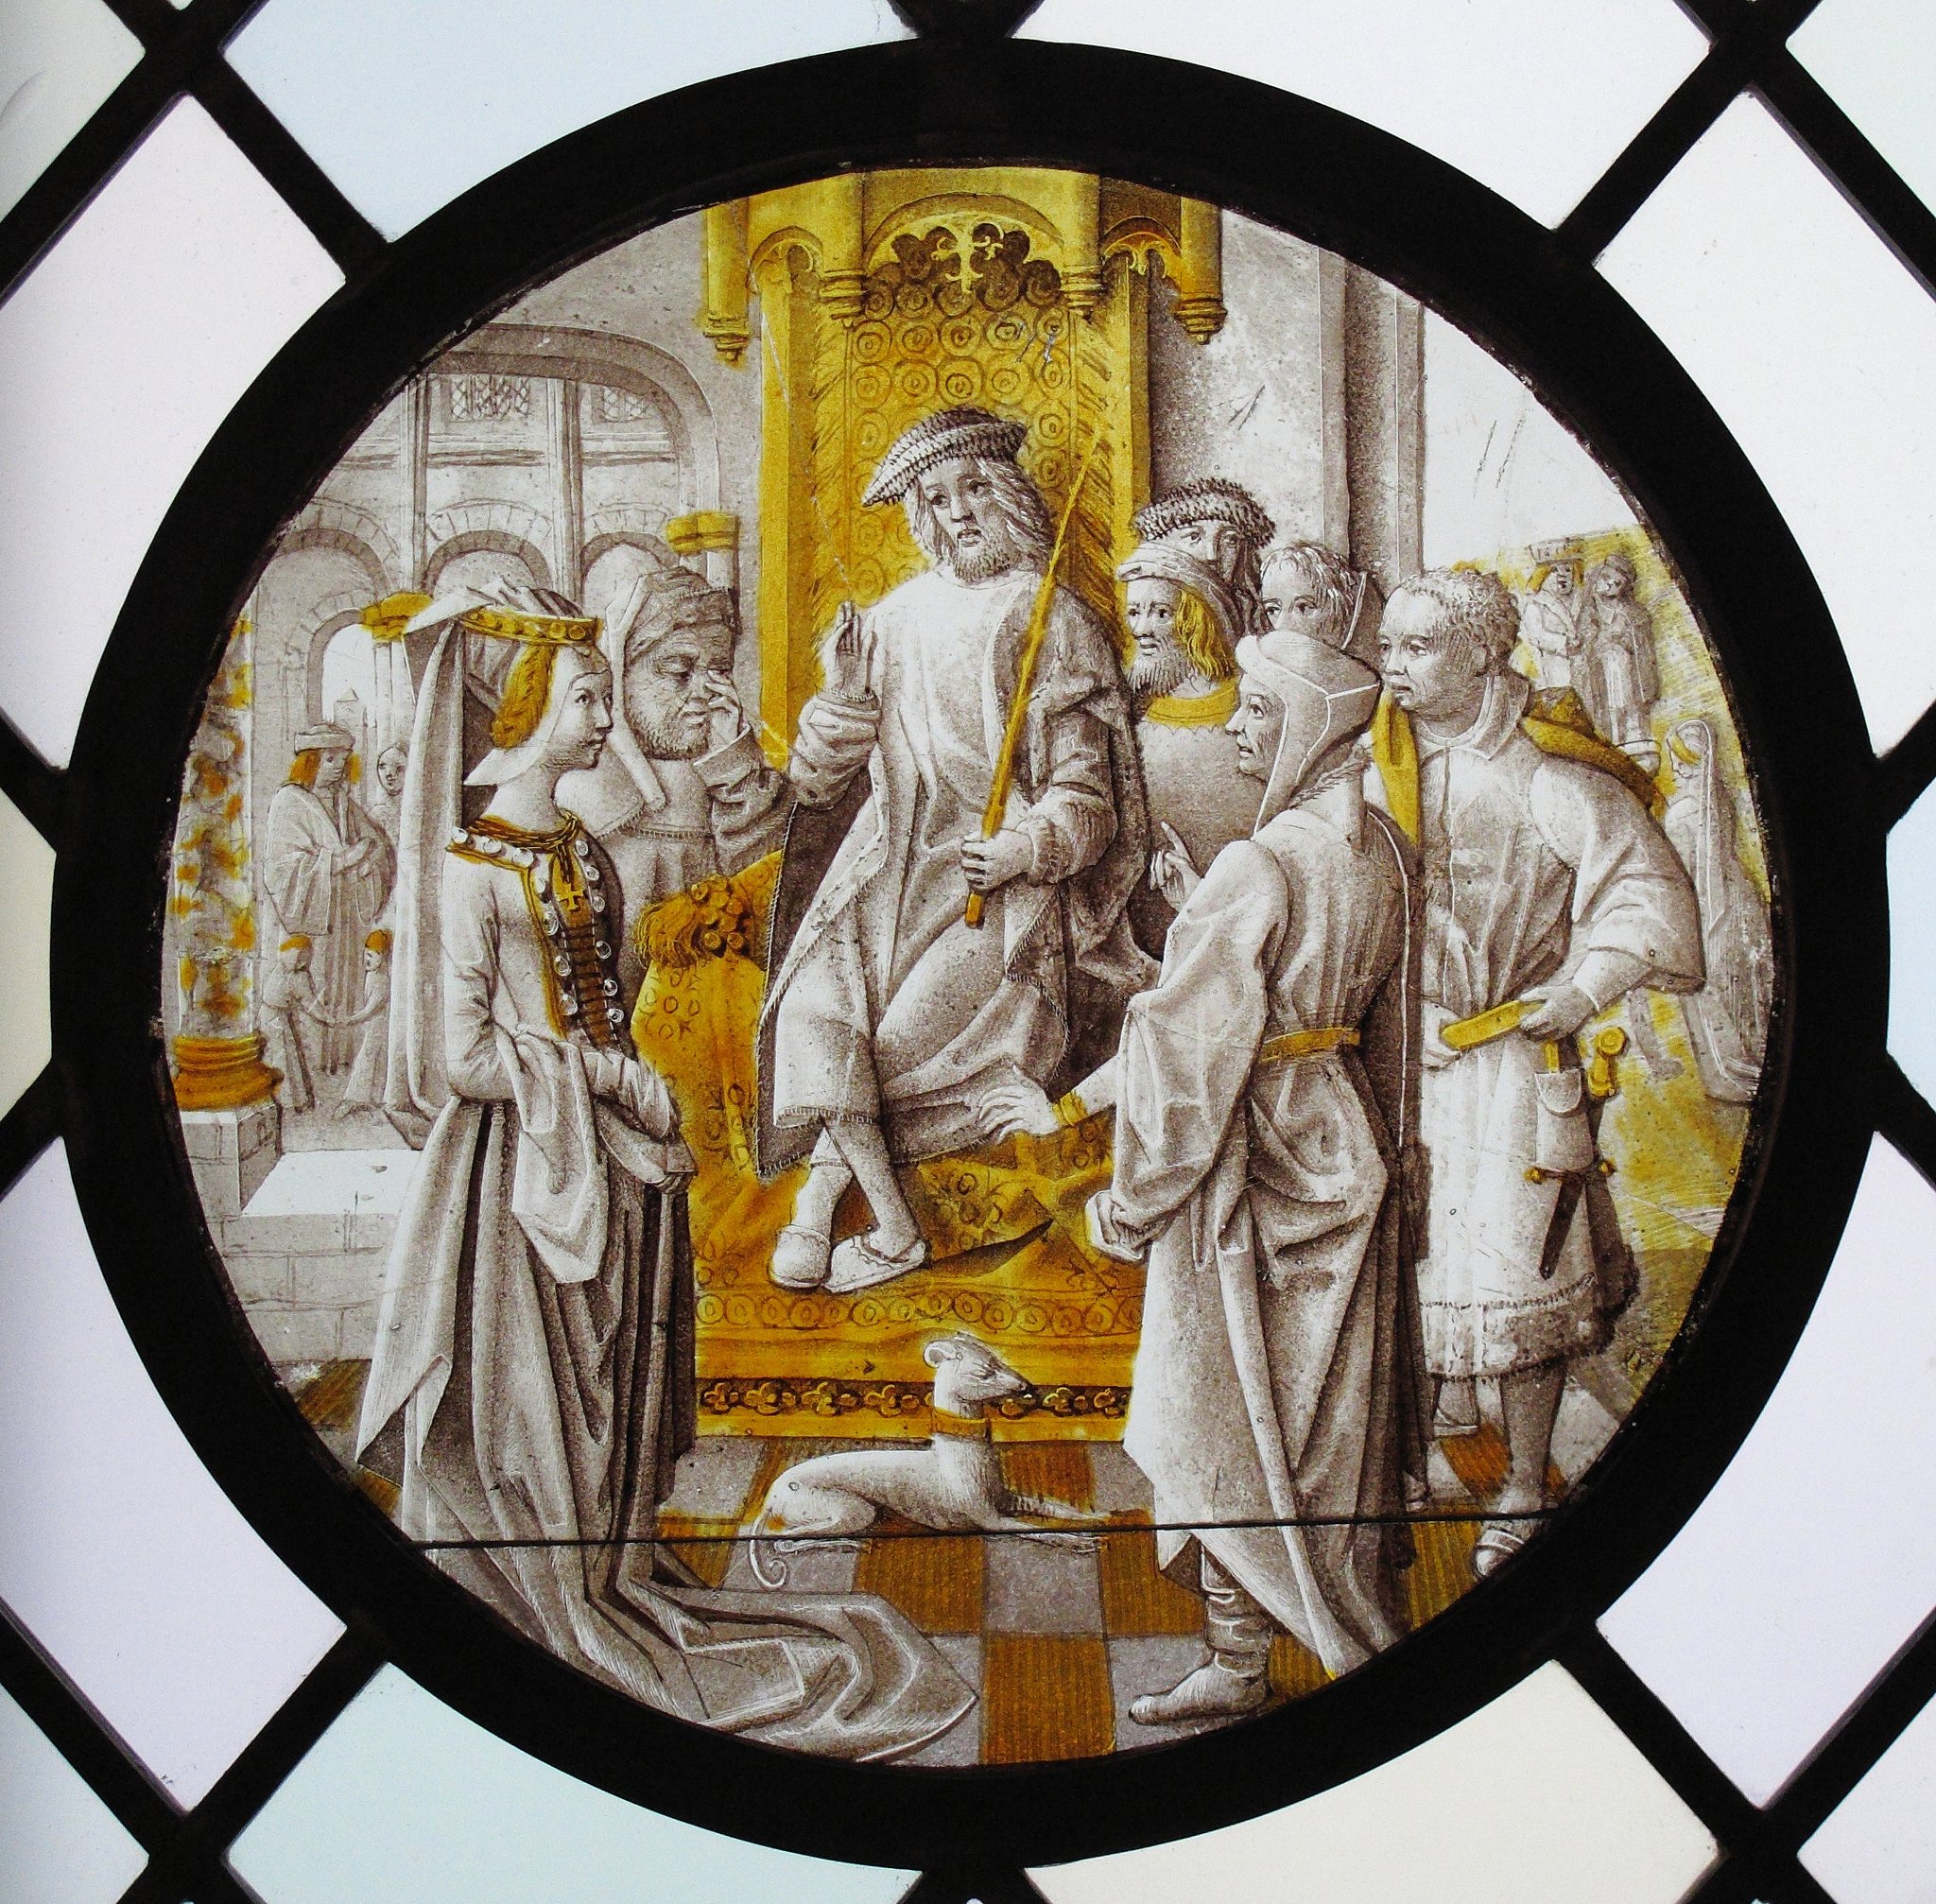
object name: roundel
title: Roundel with Susanna Before the Judge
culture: south netherlandish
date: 1510-1515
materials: glass, paint, pigment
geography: south netherlands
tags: men,women,dogs